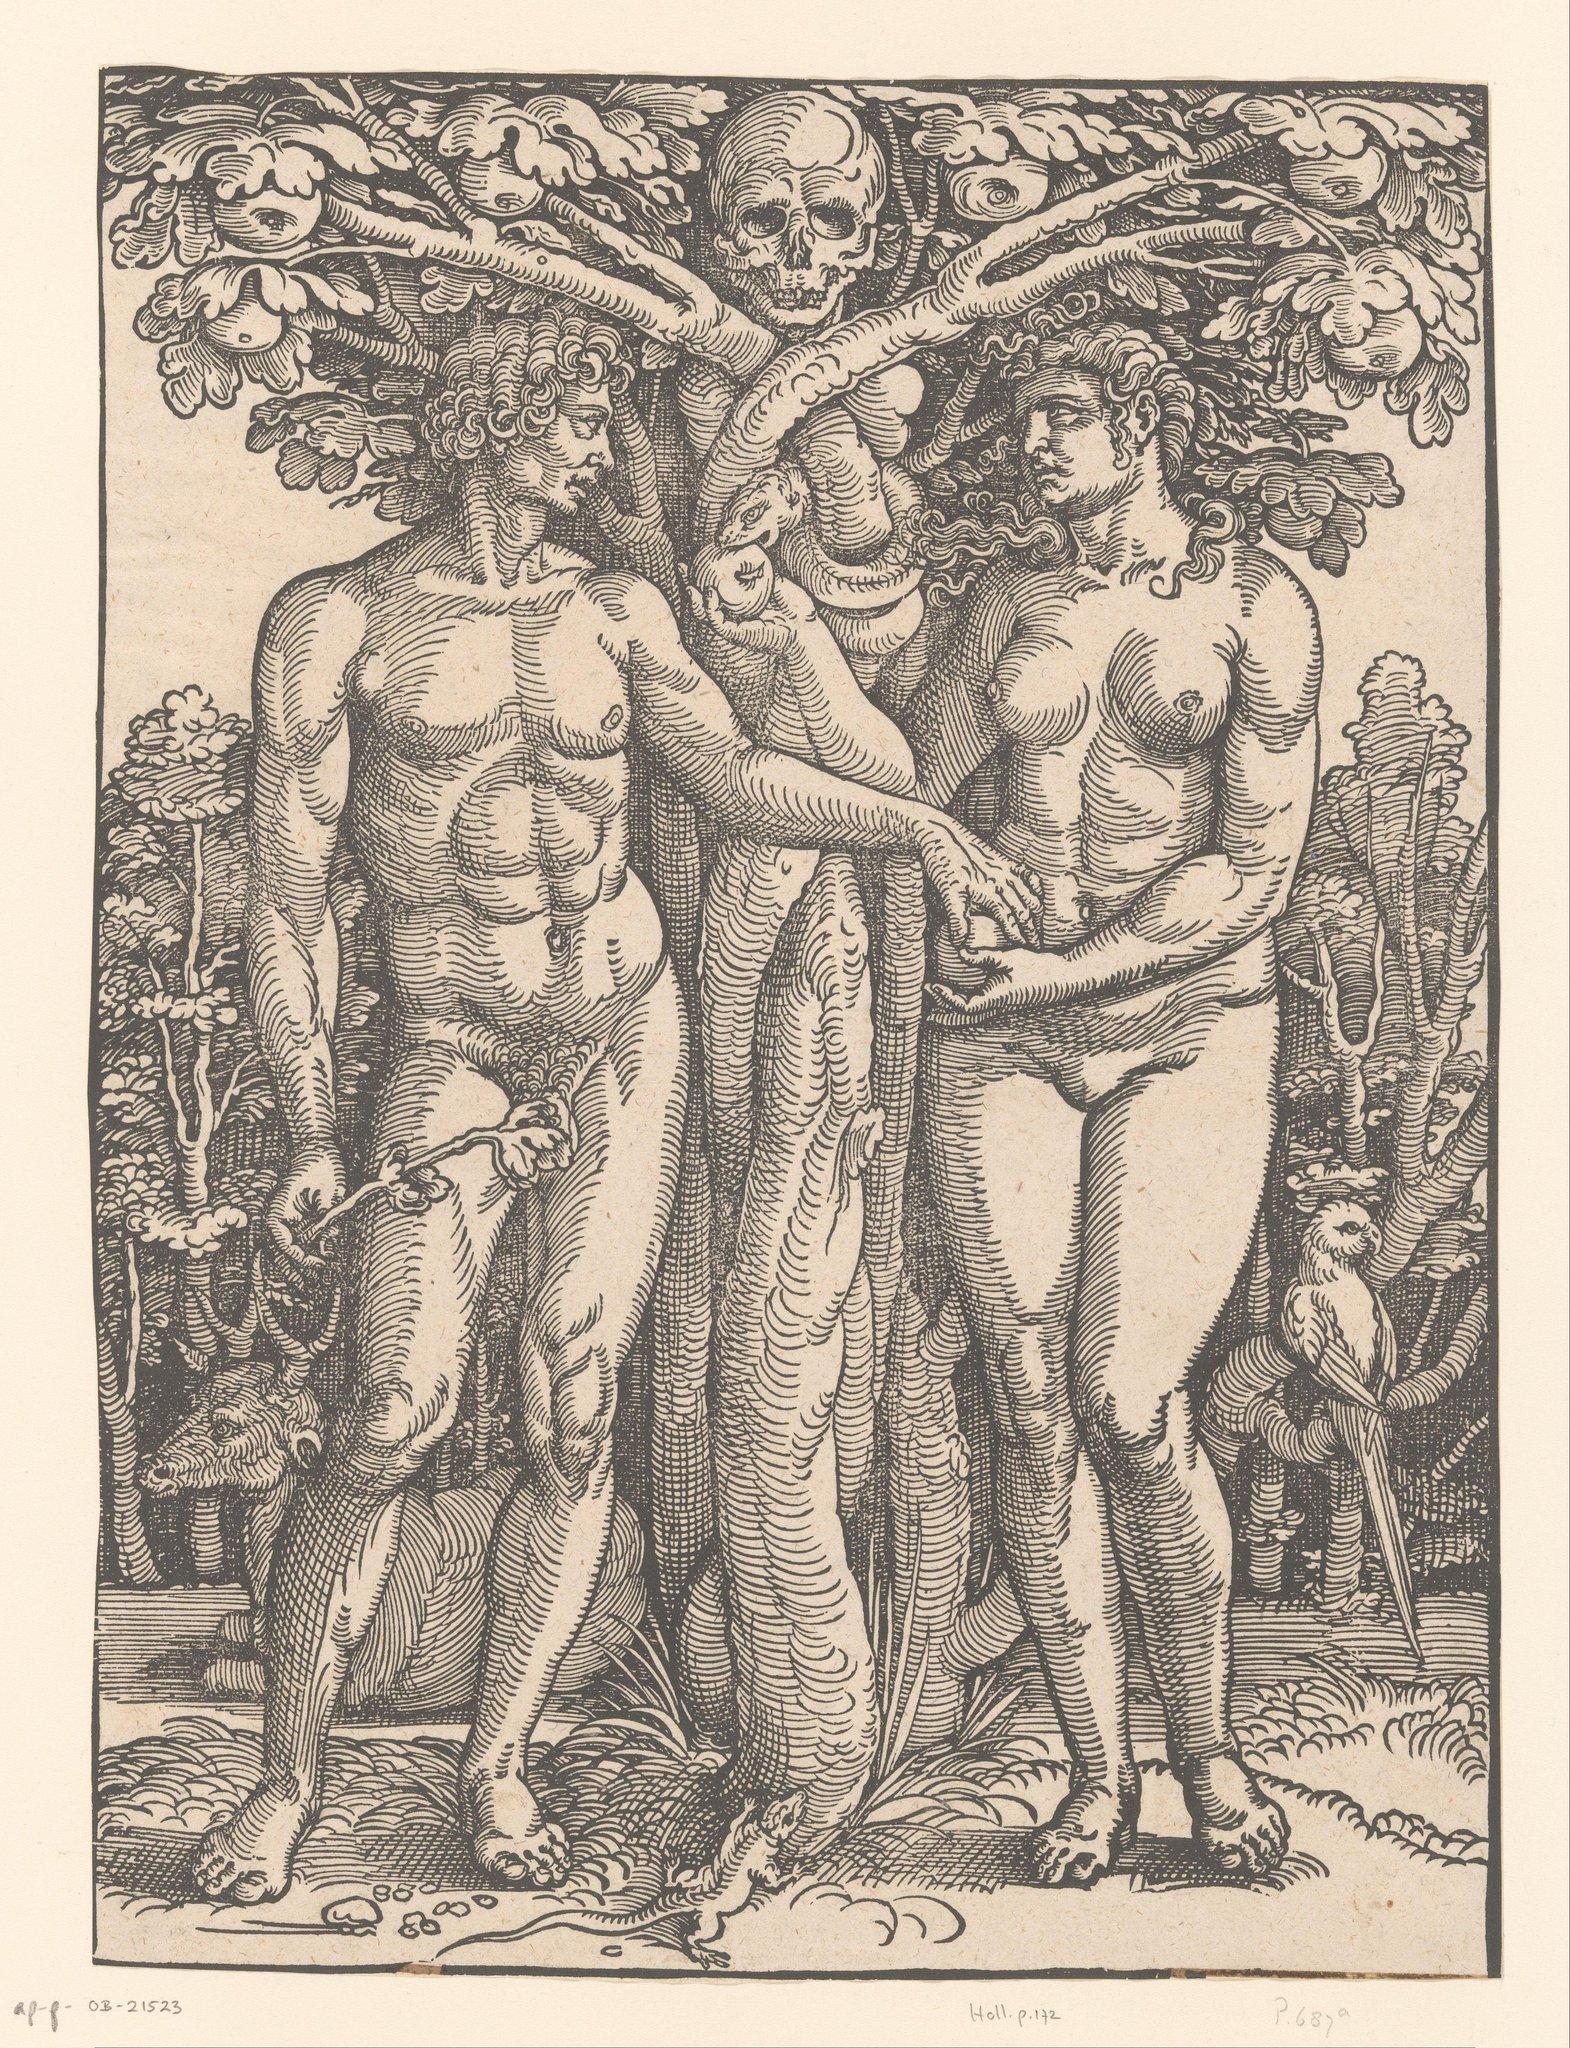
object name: print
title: Zondeval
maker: Anonymous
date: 1550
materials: paper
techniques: woodcut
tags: temptation and fall (scenes with both adam and eve)